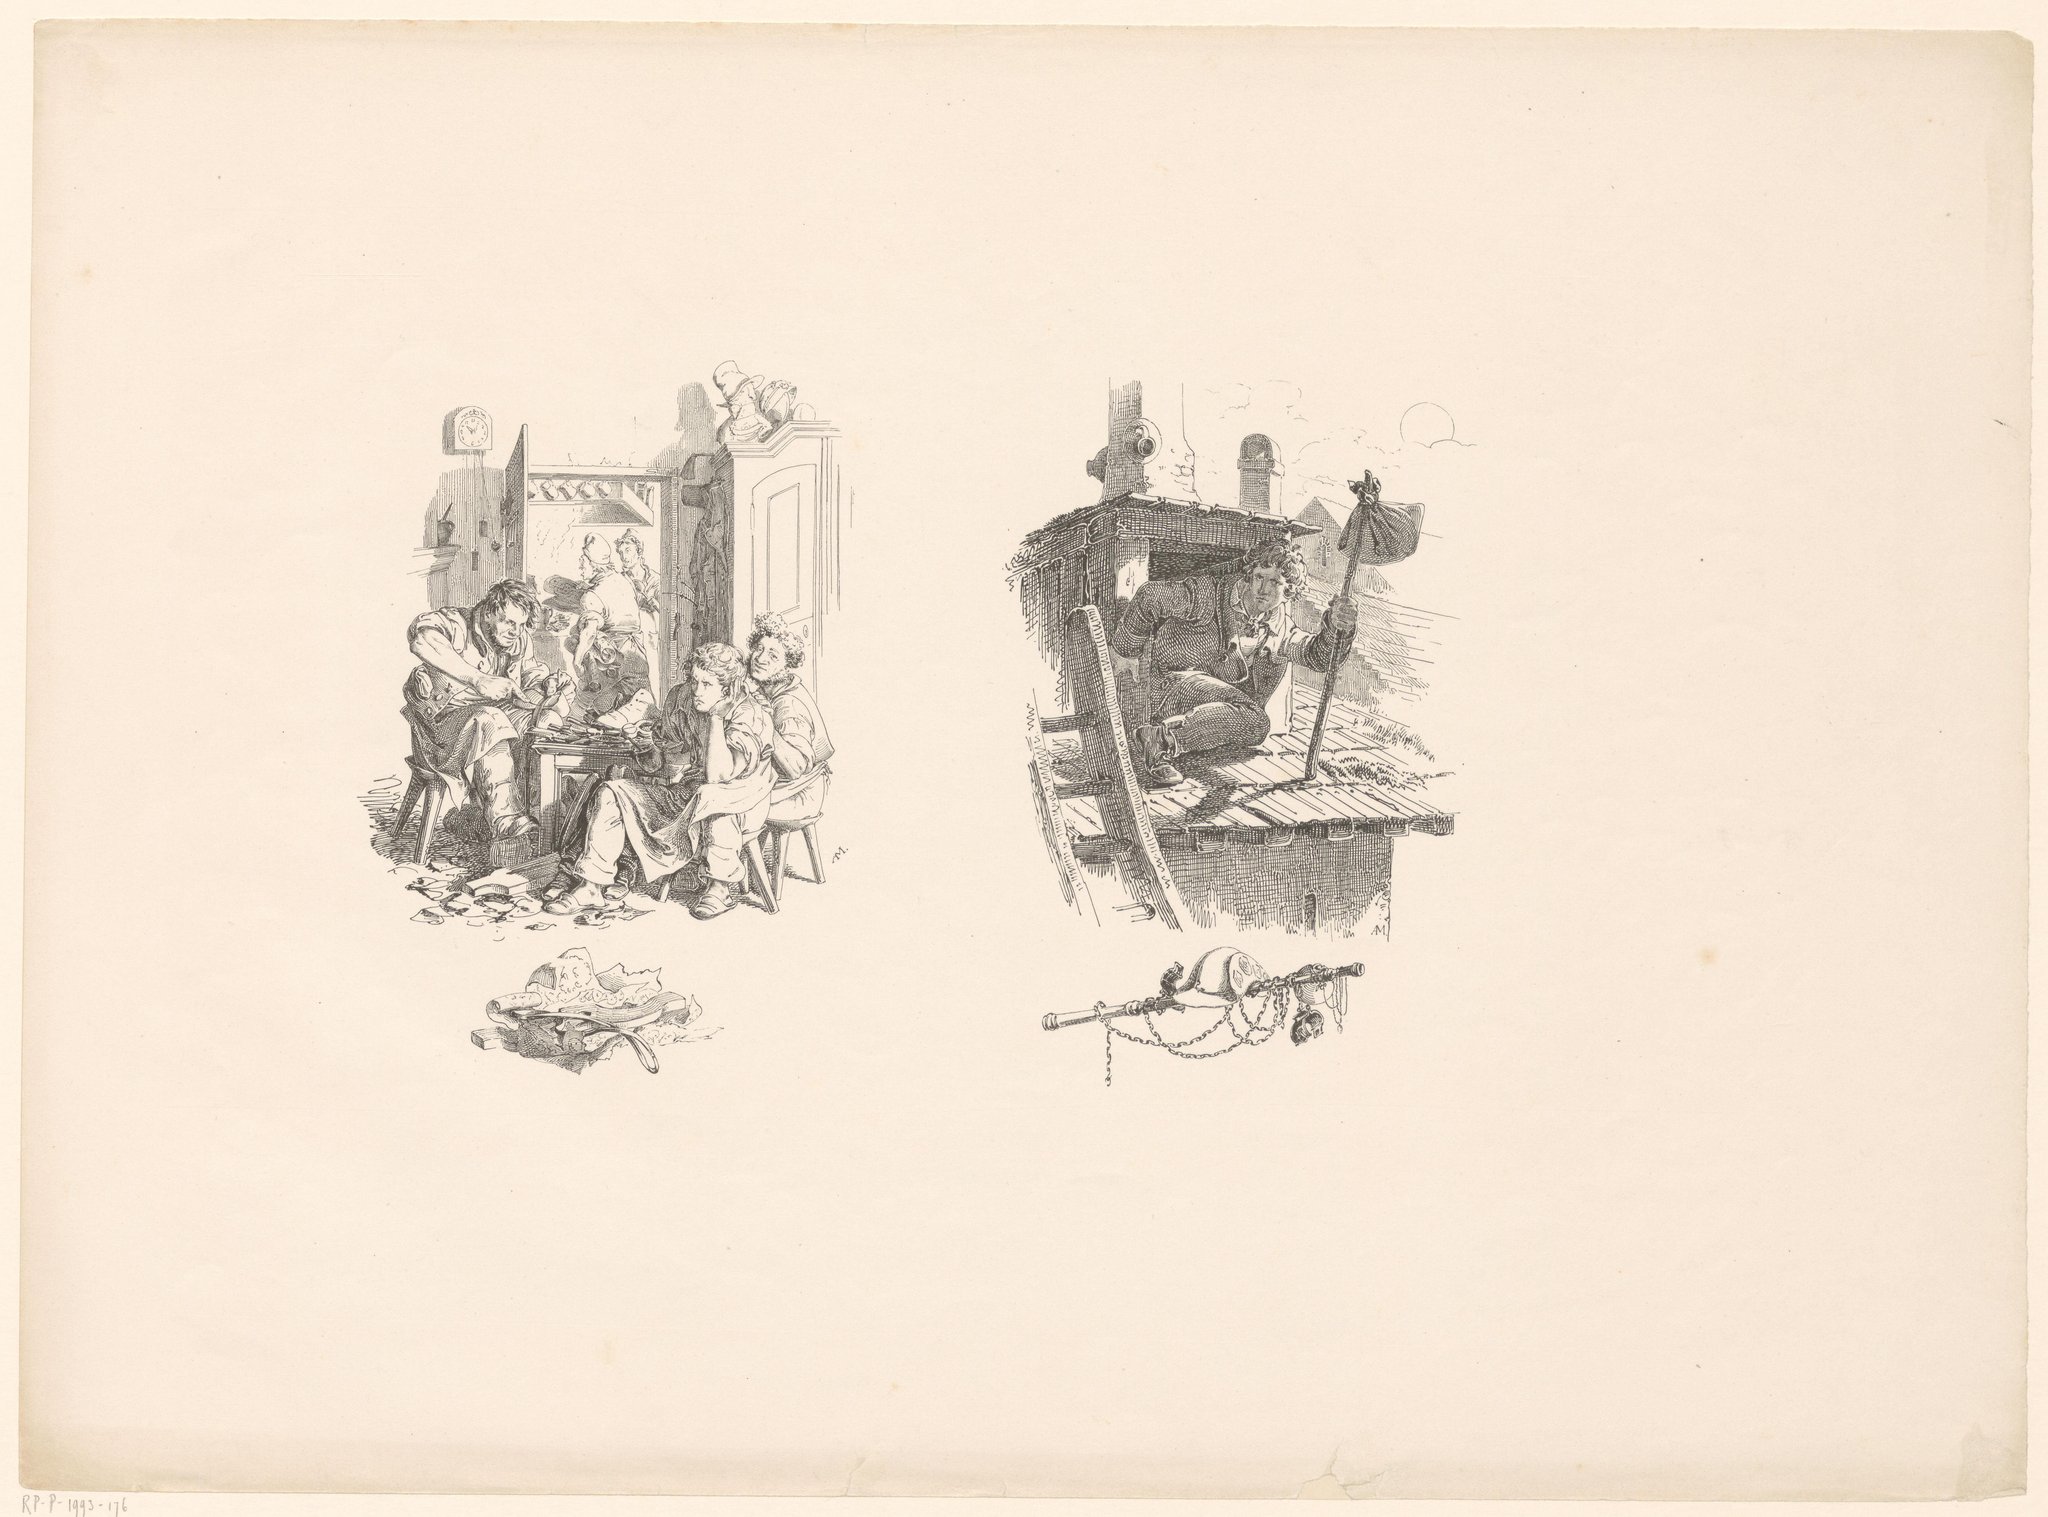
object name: print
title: Jonge kunstenaar loopt weg van huis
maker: adolph menzel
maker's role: draughtsman, painter, print maker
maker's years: 1815-1905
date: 1834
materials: paper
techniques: pen lithography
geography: berlin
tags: elopement, running away, artist (in general)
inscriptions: collector's mark: Lugt 2228, collector's mark: Lugt 2760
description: Jongeman aan het werk in een schoenmakerswerkplaats, waar zijn tekeningen verbrand worden. Op de scène ernaast klimt hij uit een zolderraam en loopt weg van huis.